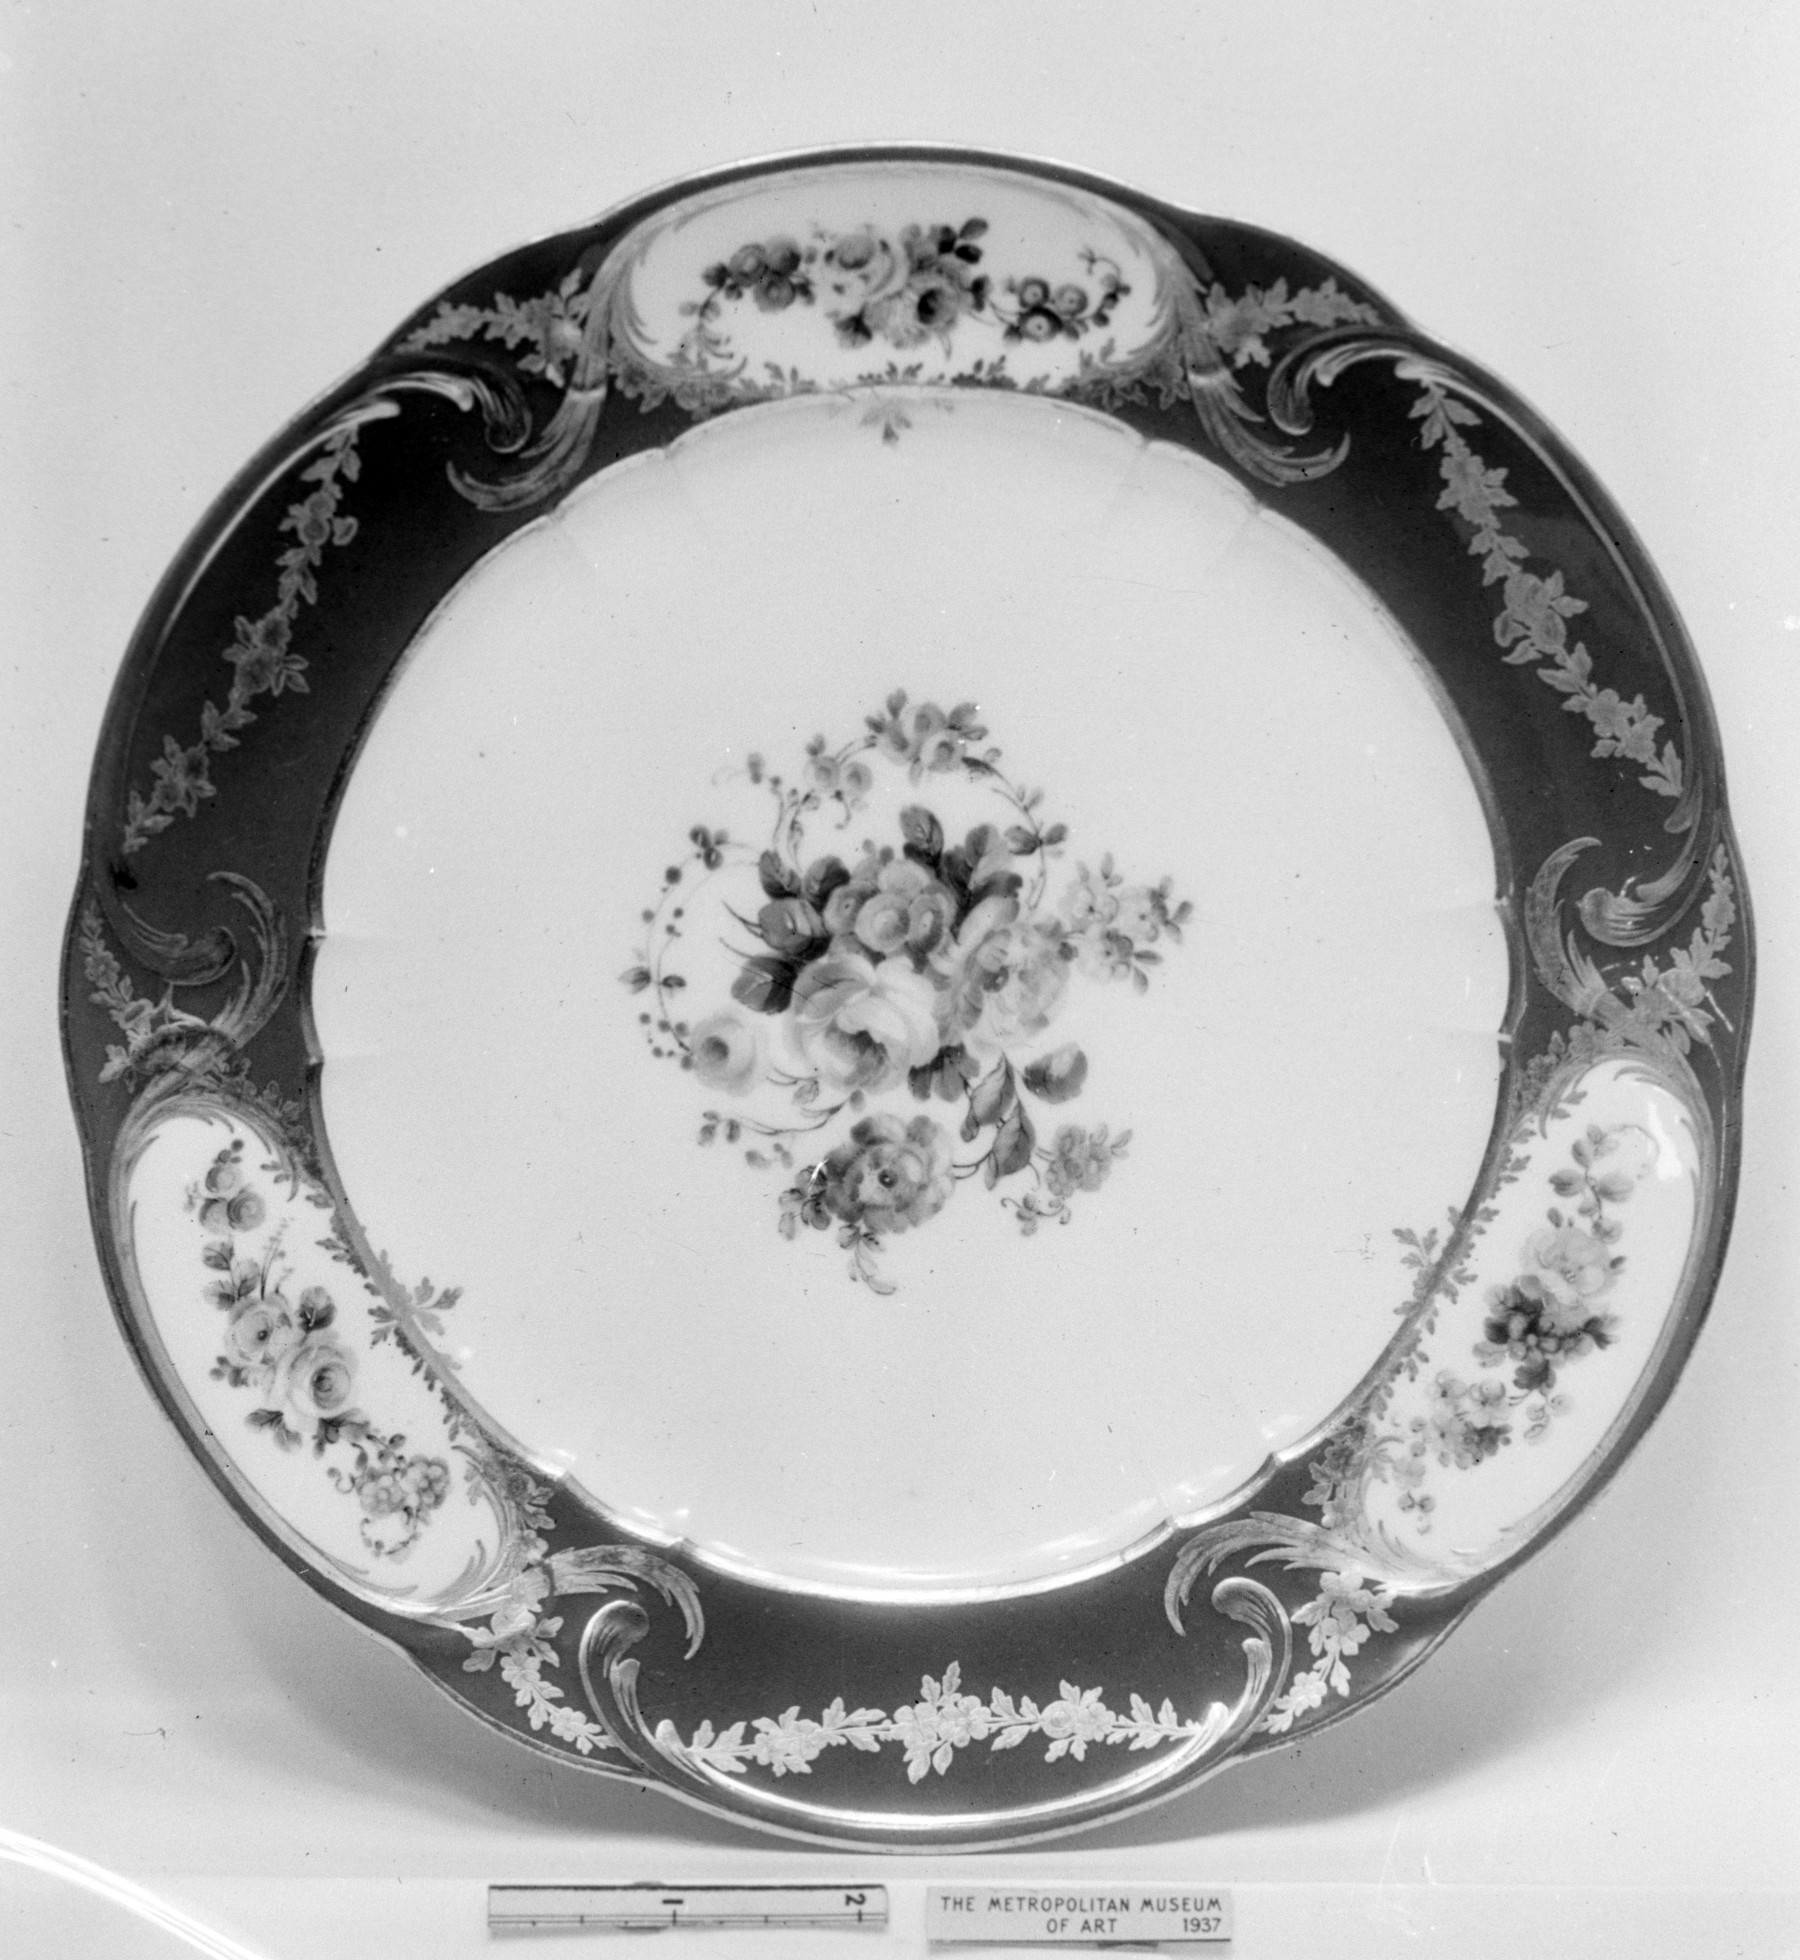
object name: plate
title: Plate (Assiette à palmes) (1 of 102) (part of a service)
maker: sèvres manufactory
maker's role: manufactory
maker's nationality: french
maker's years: 1740-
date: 1772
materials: soft paste porcelain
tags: flowers